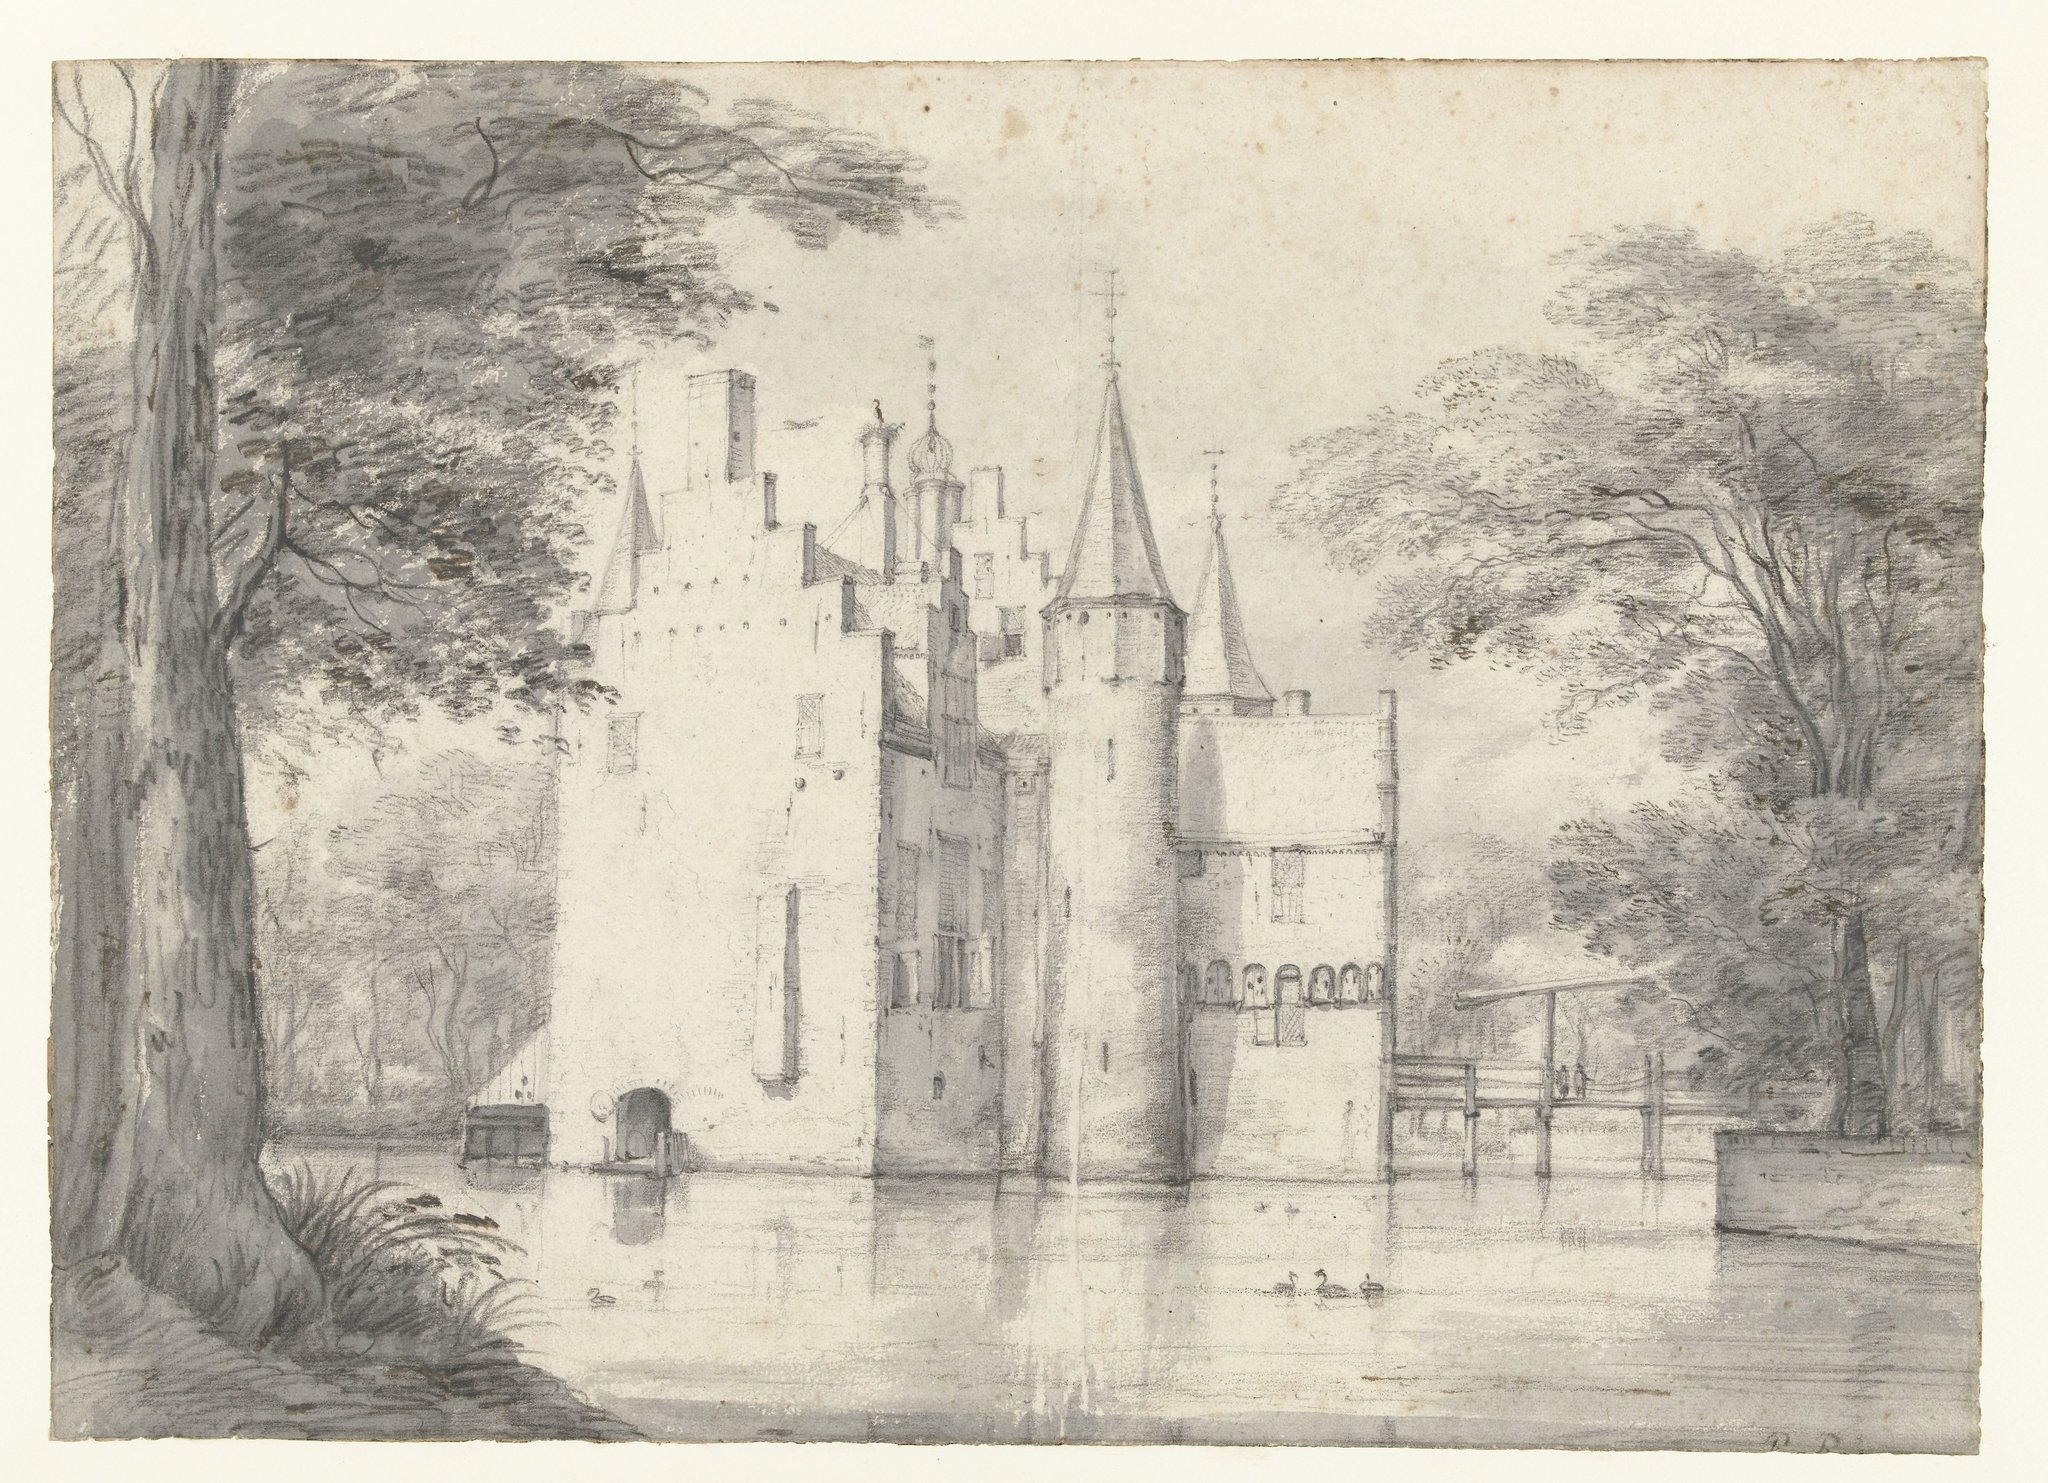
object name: drawing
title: Swieten Castle from the west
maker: roelant roghman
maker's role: draughtsman, painter, print maker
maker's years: 1627-1692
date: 1646-1647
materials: chalk, paper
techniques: brush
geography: kasteel swieten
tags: castle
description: Roghman made drawings of Swieten Castle in Zoeterwoude from four different vantage points, two of which are owned by the Rijksmuseum. He has surrounded the sun-drenched castle with trees to graceful effect. The resulting picturesque atmosphere is further intensified by the ducks in the pond, the stork’s nest atop the chimney, and the figures on the bridge.